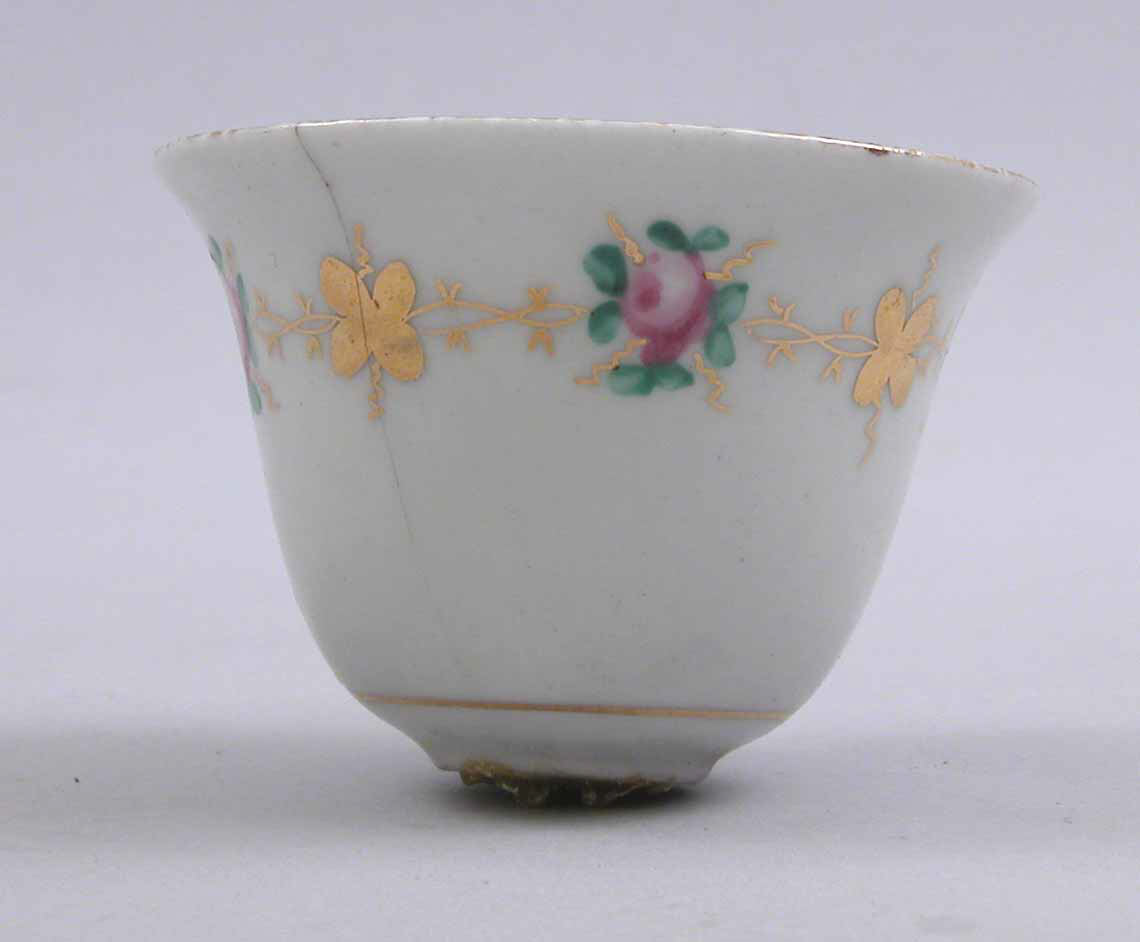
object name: cup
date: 1801-1900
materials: porcelain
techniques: gilding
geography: turkey